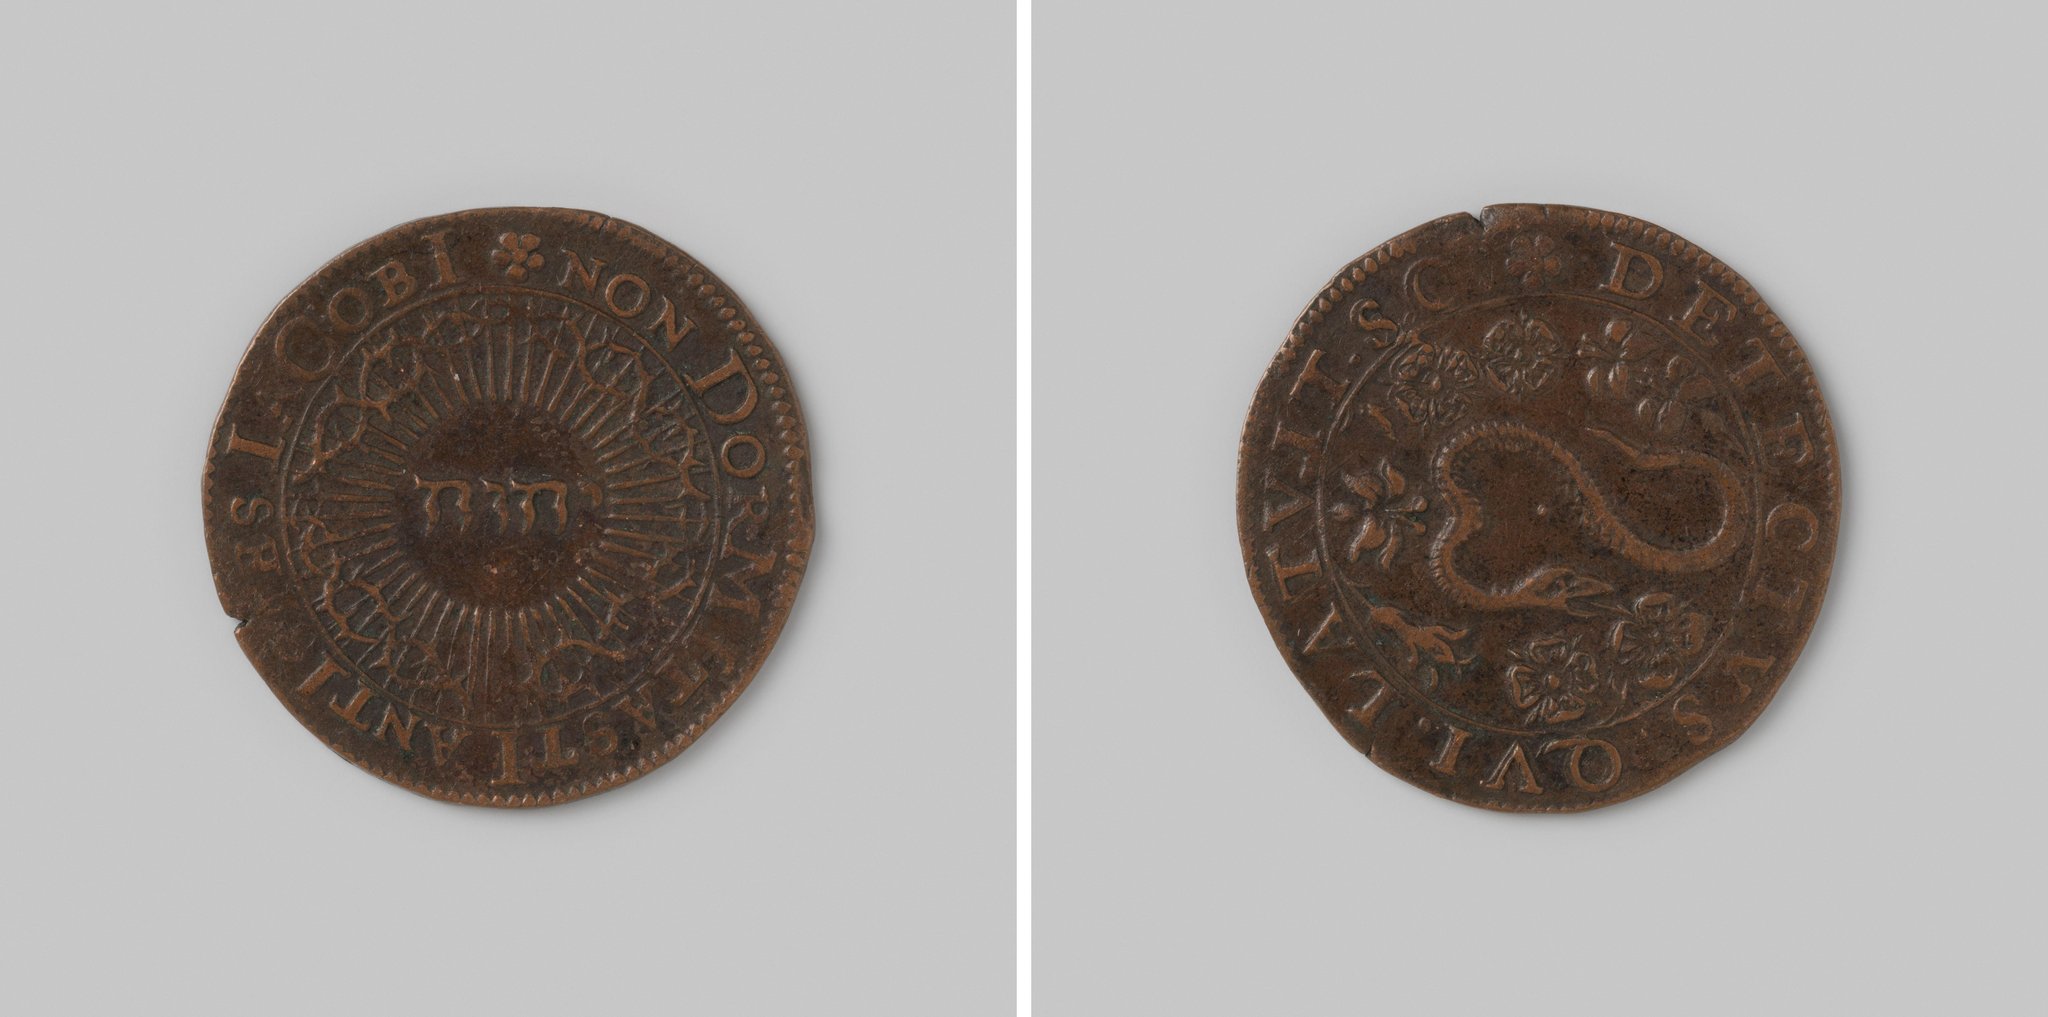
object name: history medal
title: Rekenpenning uit Dordrecht op de mislukte aanslag op het Parlement in Londen 1605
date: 1605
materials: copper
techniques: striking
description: Koperen penning, op de voorzijde de stralende naam Gods in een doornenkroon, met omschrift, op de keerzijde een slang tussen de bloemen, met omschrift.